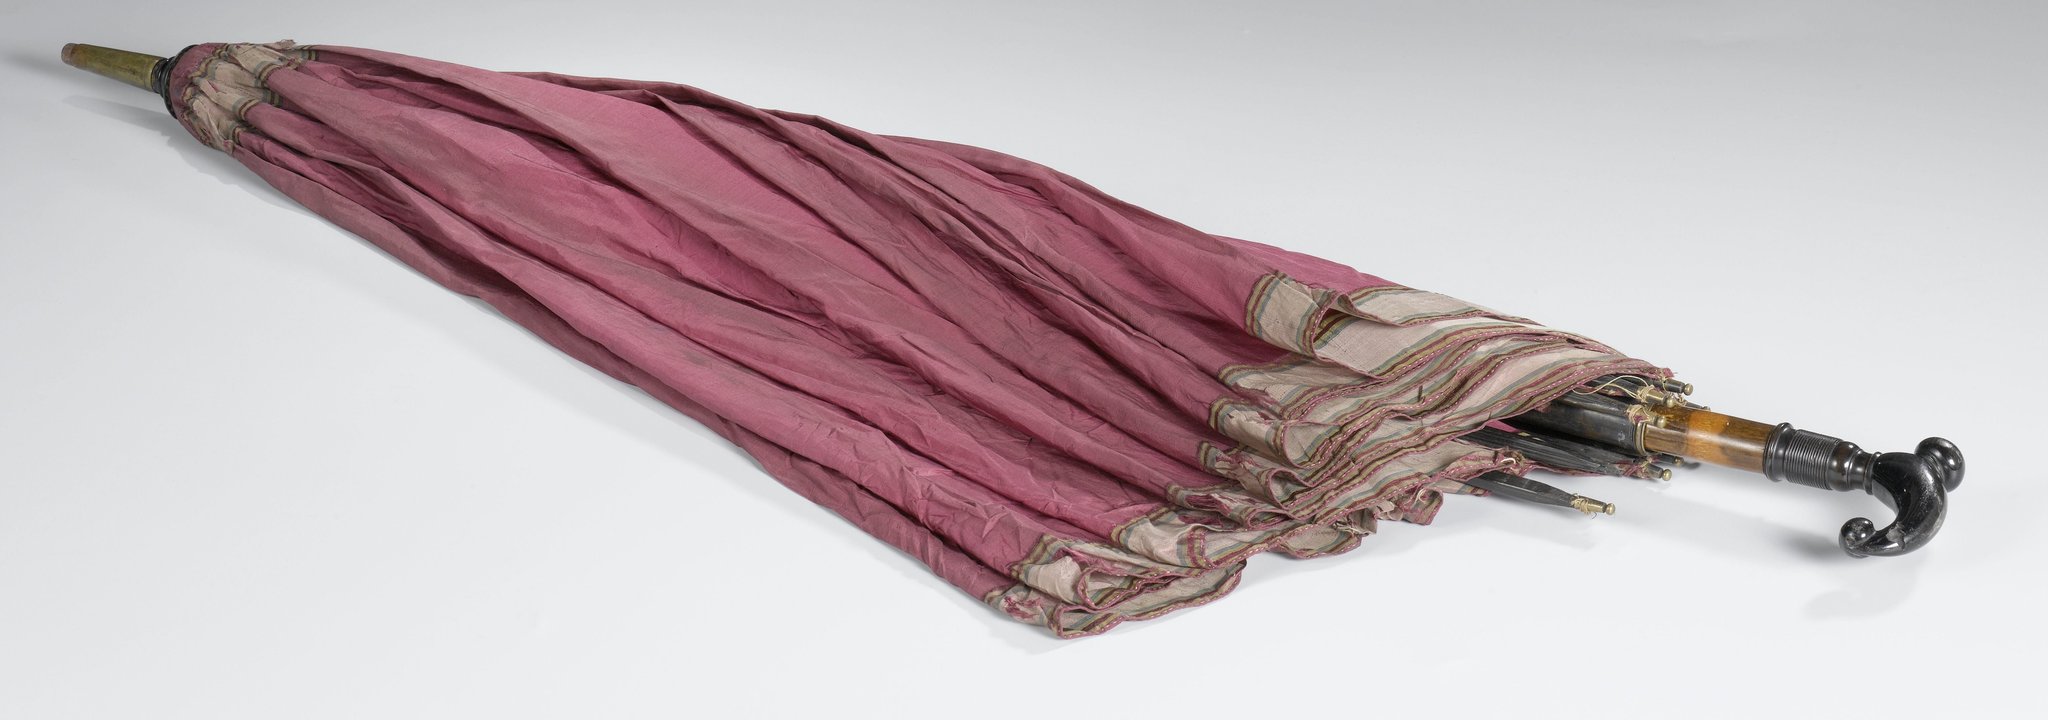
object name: umbrella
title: Paraplu met dek van donkerroze zijde en een gestreepte rand, op een wortelnoten stok waaraan een zwarte knop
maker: Anonymous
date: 1830-1850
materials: baleen, copper, silk, wood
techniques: casting, cutting, lacquer, weave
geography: france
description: Paraplu met dek van donkerroze zijde en een ingeweven gestreepte rand aan de onder- en bovenkant. Ongevoerd, met tien walvisbaleinen, waaran koperen punten. Op wortelnoten stok waaraan een zwarte knop met een kleine sierlijke boog. Heel brede koperen schuif. Bovenop een koperen punt. Los erbij een ring van been.